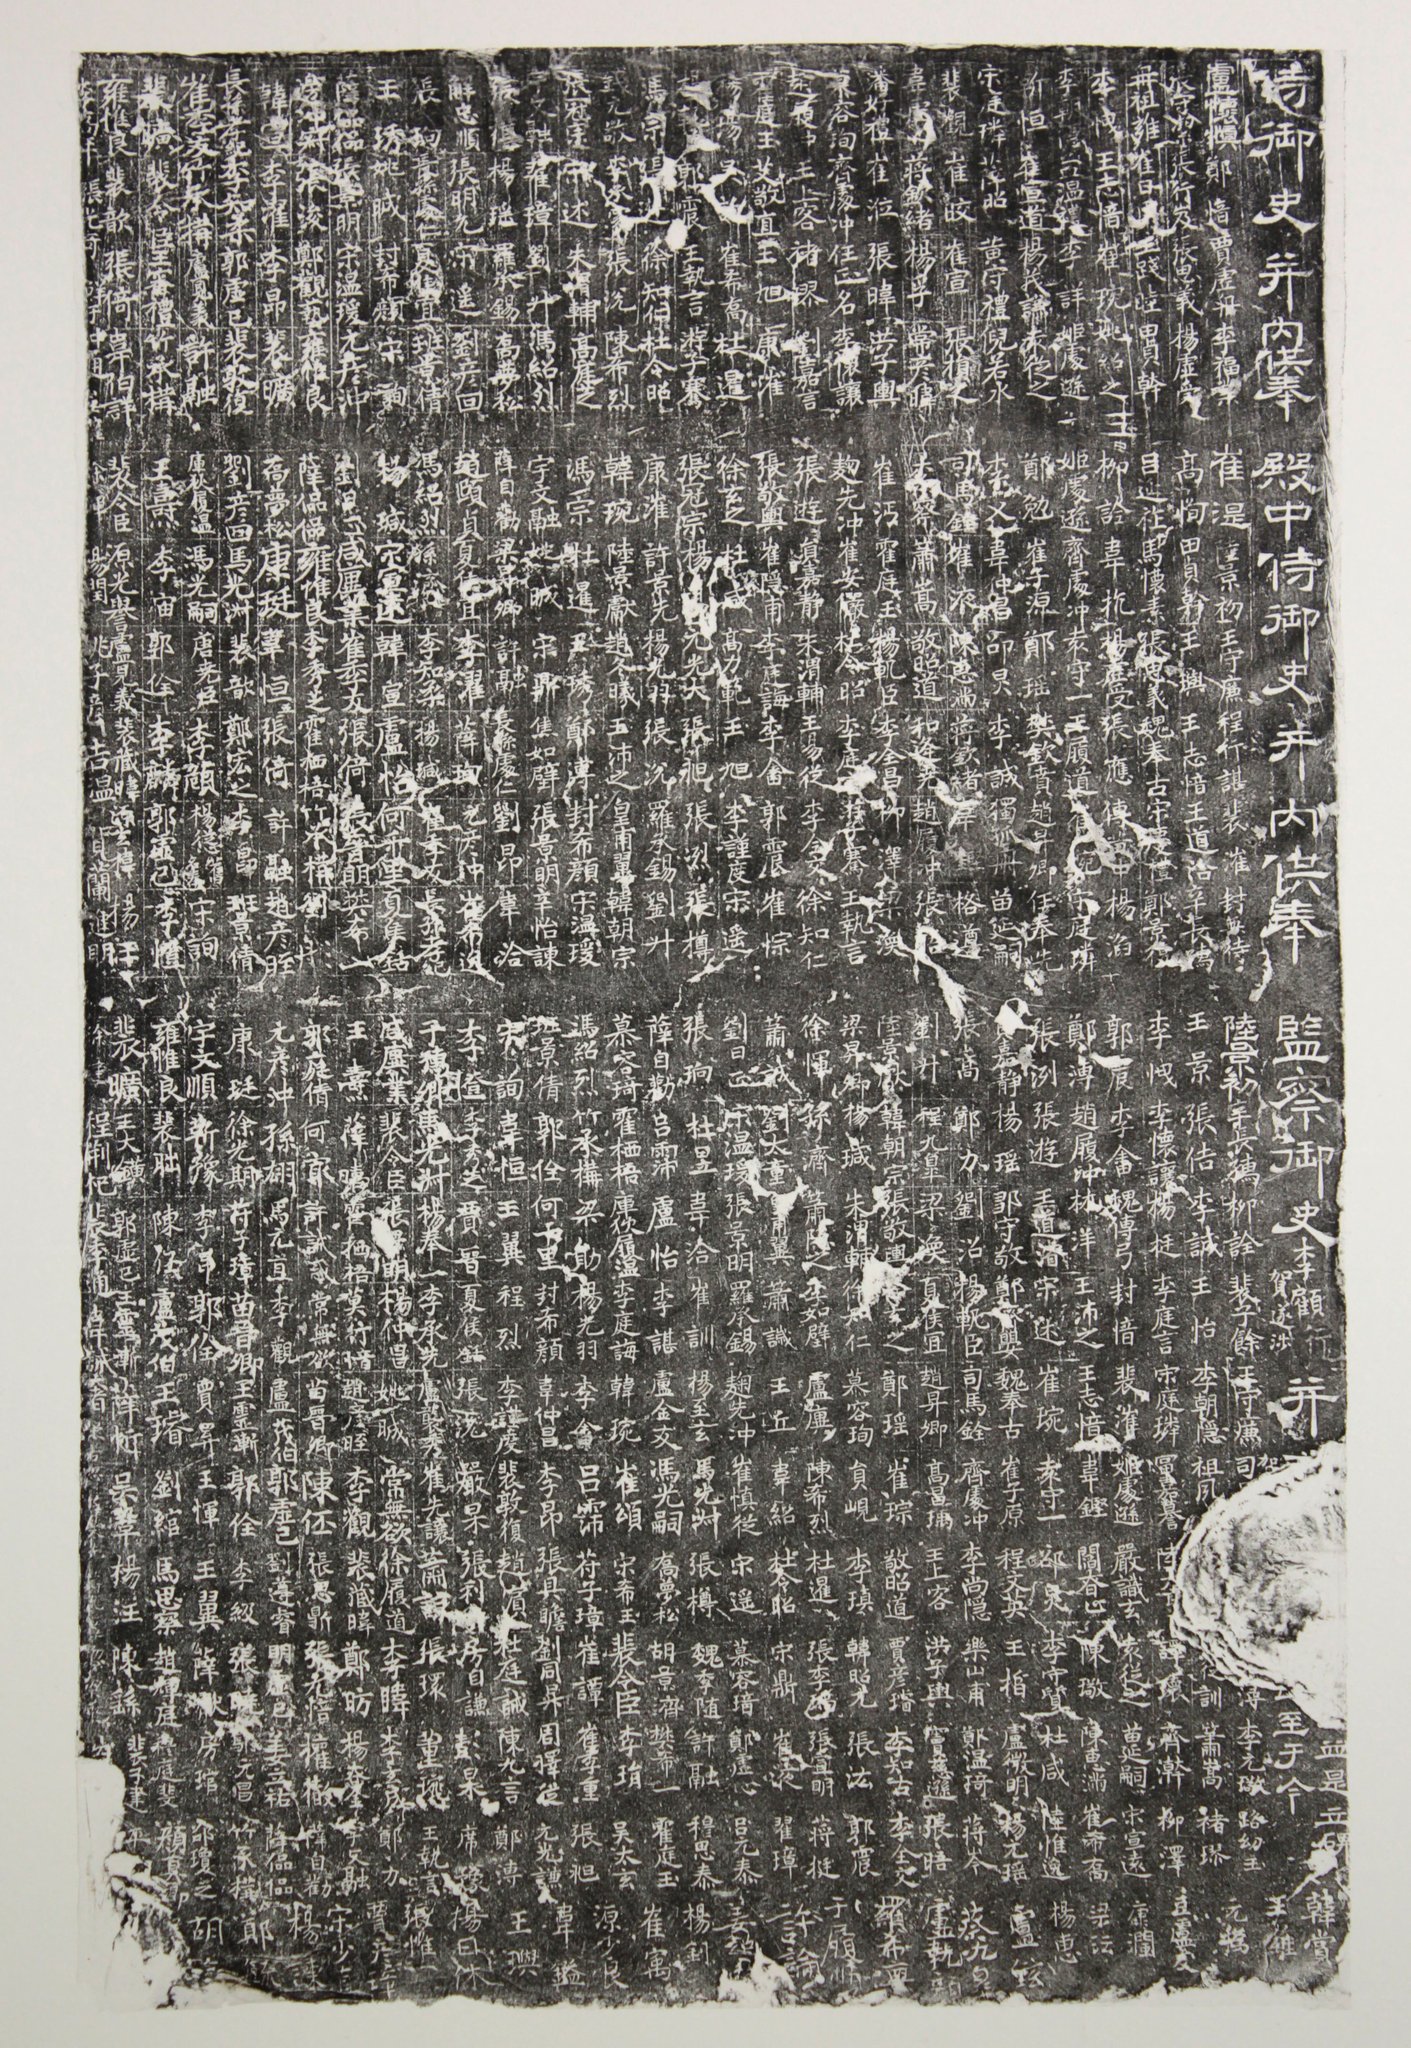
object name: rubbing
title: List of Censors, engraved on the back of the Stele for Yushitai Jingshe (1977.375.26)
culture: chinese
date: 1901-2000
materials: ink, paper